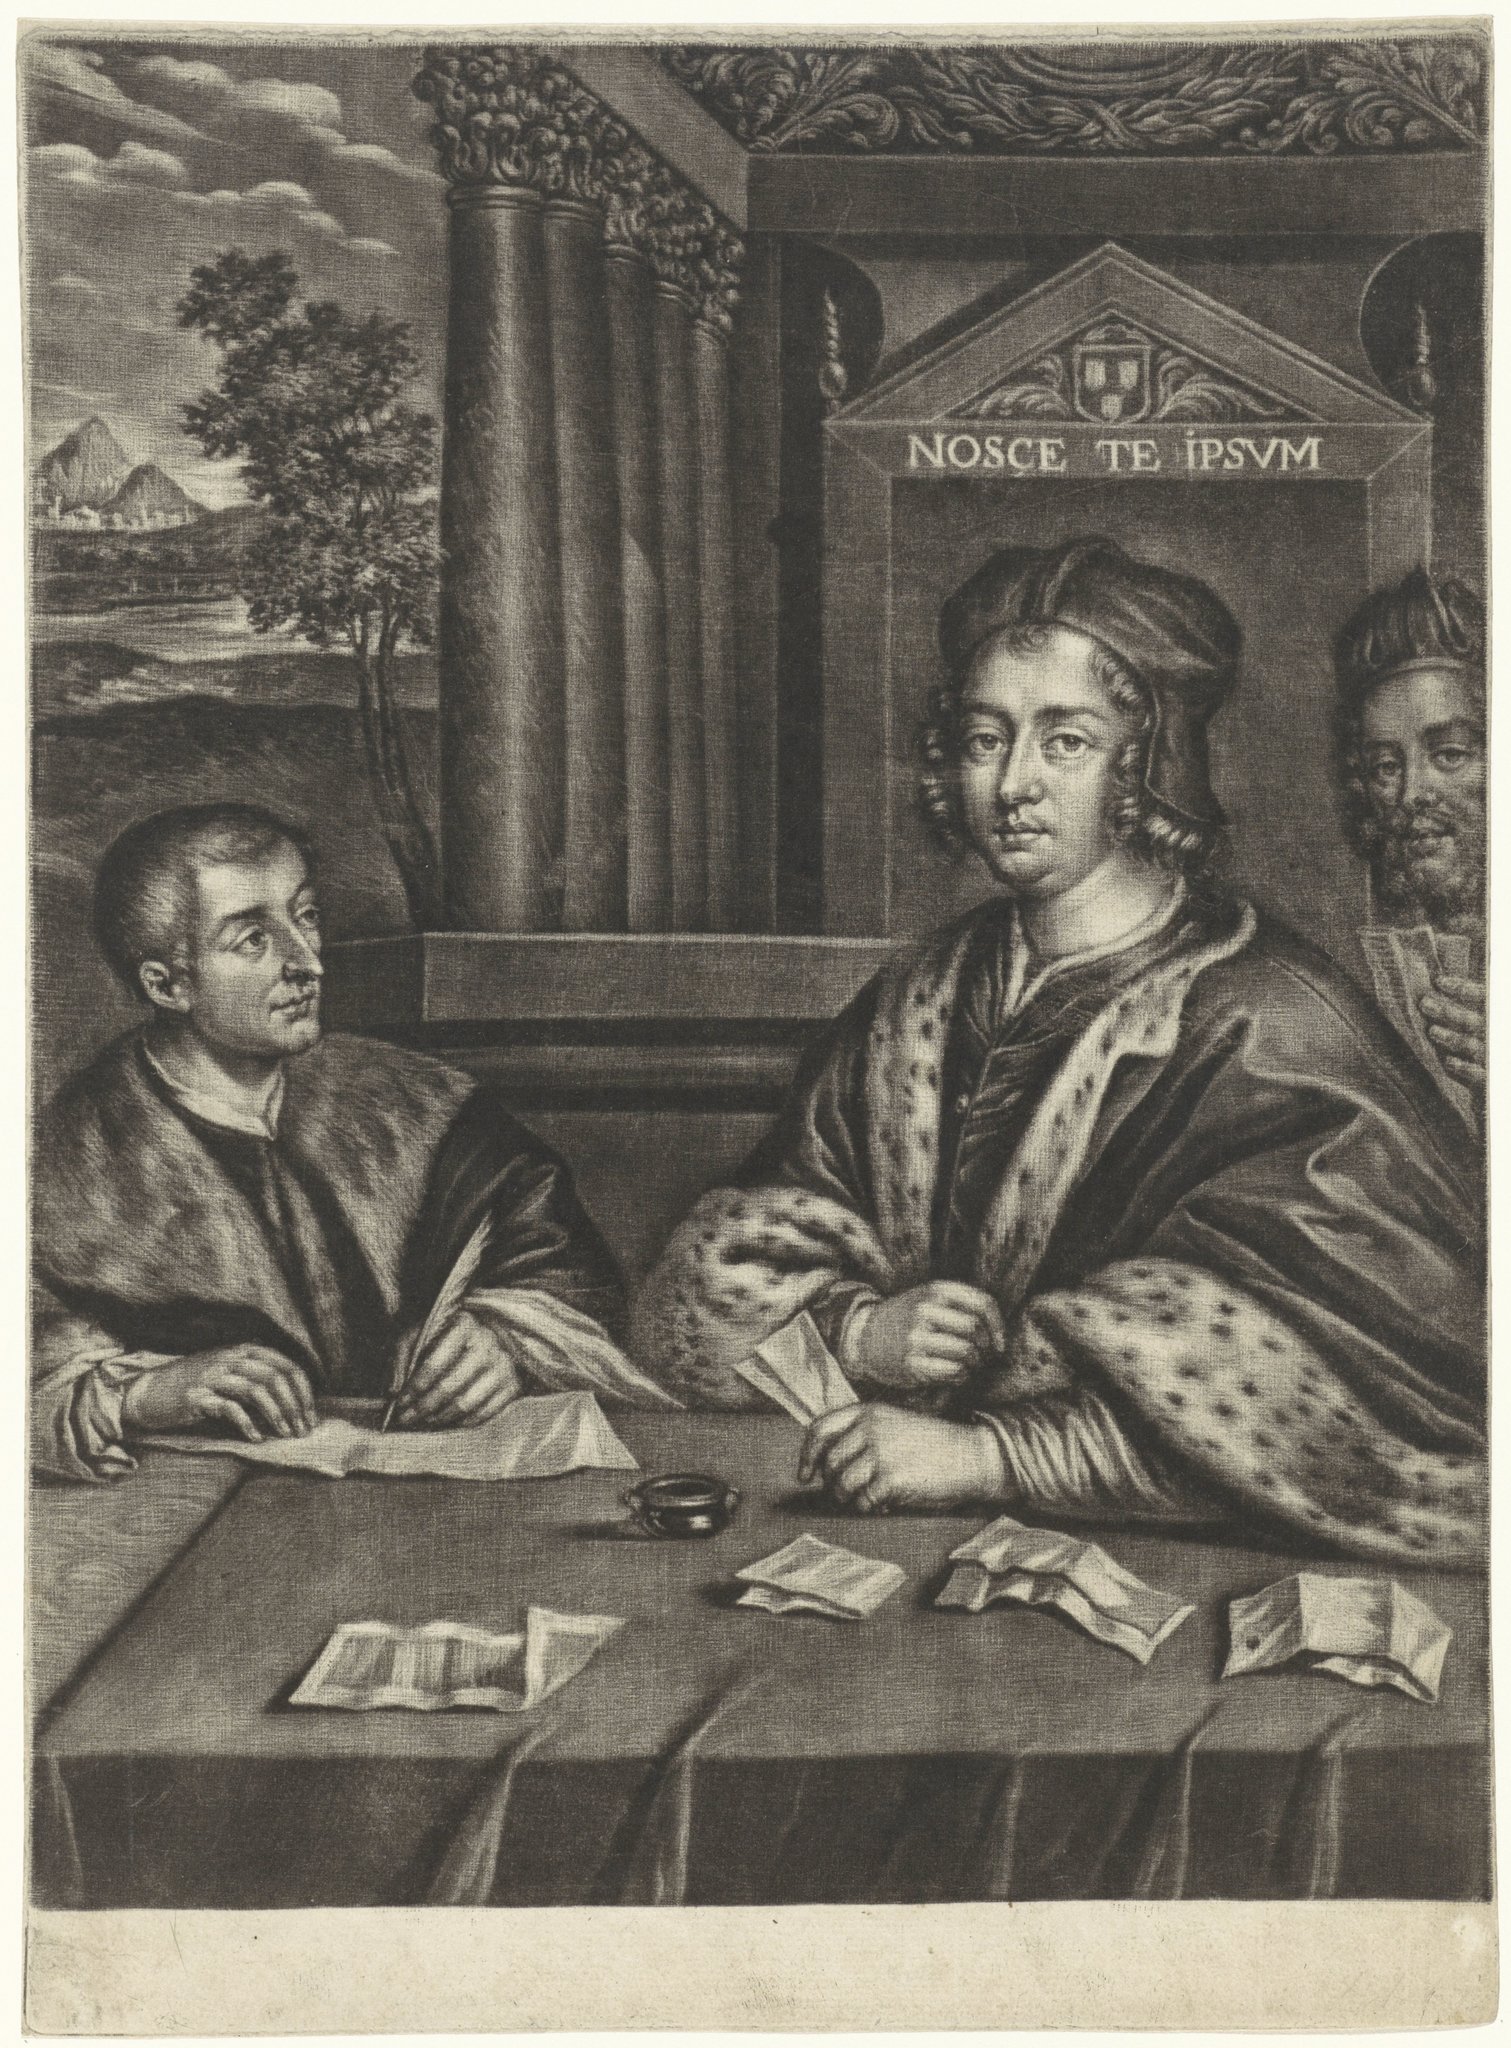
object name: print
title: Portret van Ferry Carondelet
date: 1676-1750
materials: paper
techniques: mezzotint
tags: clergyman, lawyer, attorney at law, paper (writing material)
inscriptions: collector's mark: Lugt 2228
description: De jurist, diplomaat en priester Ferry Carondelet zit achter een tafel waarop enkele papieren met zegels. Naast hem zijn secretaris.